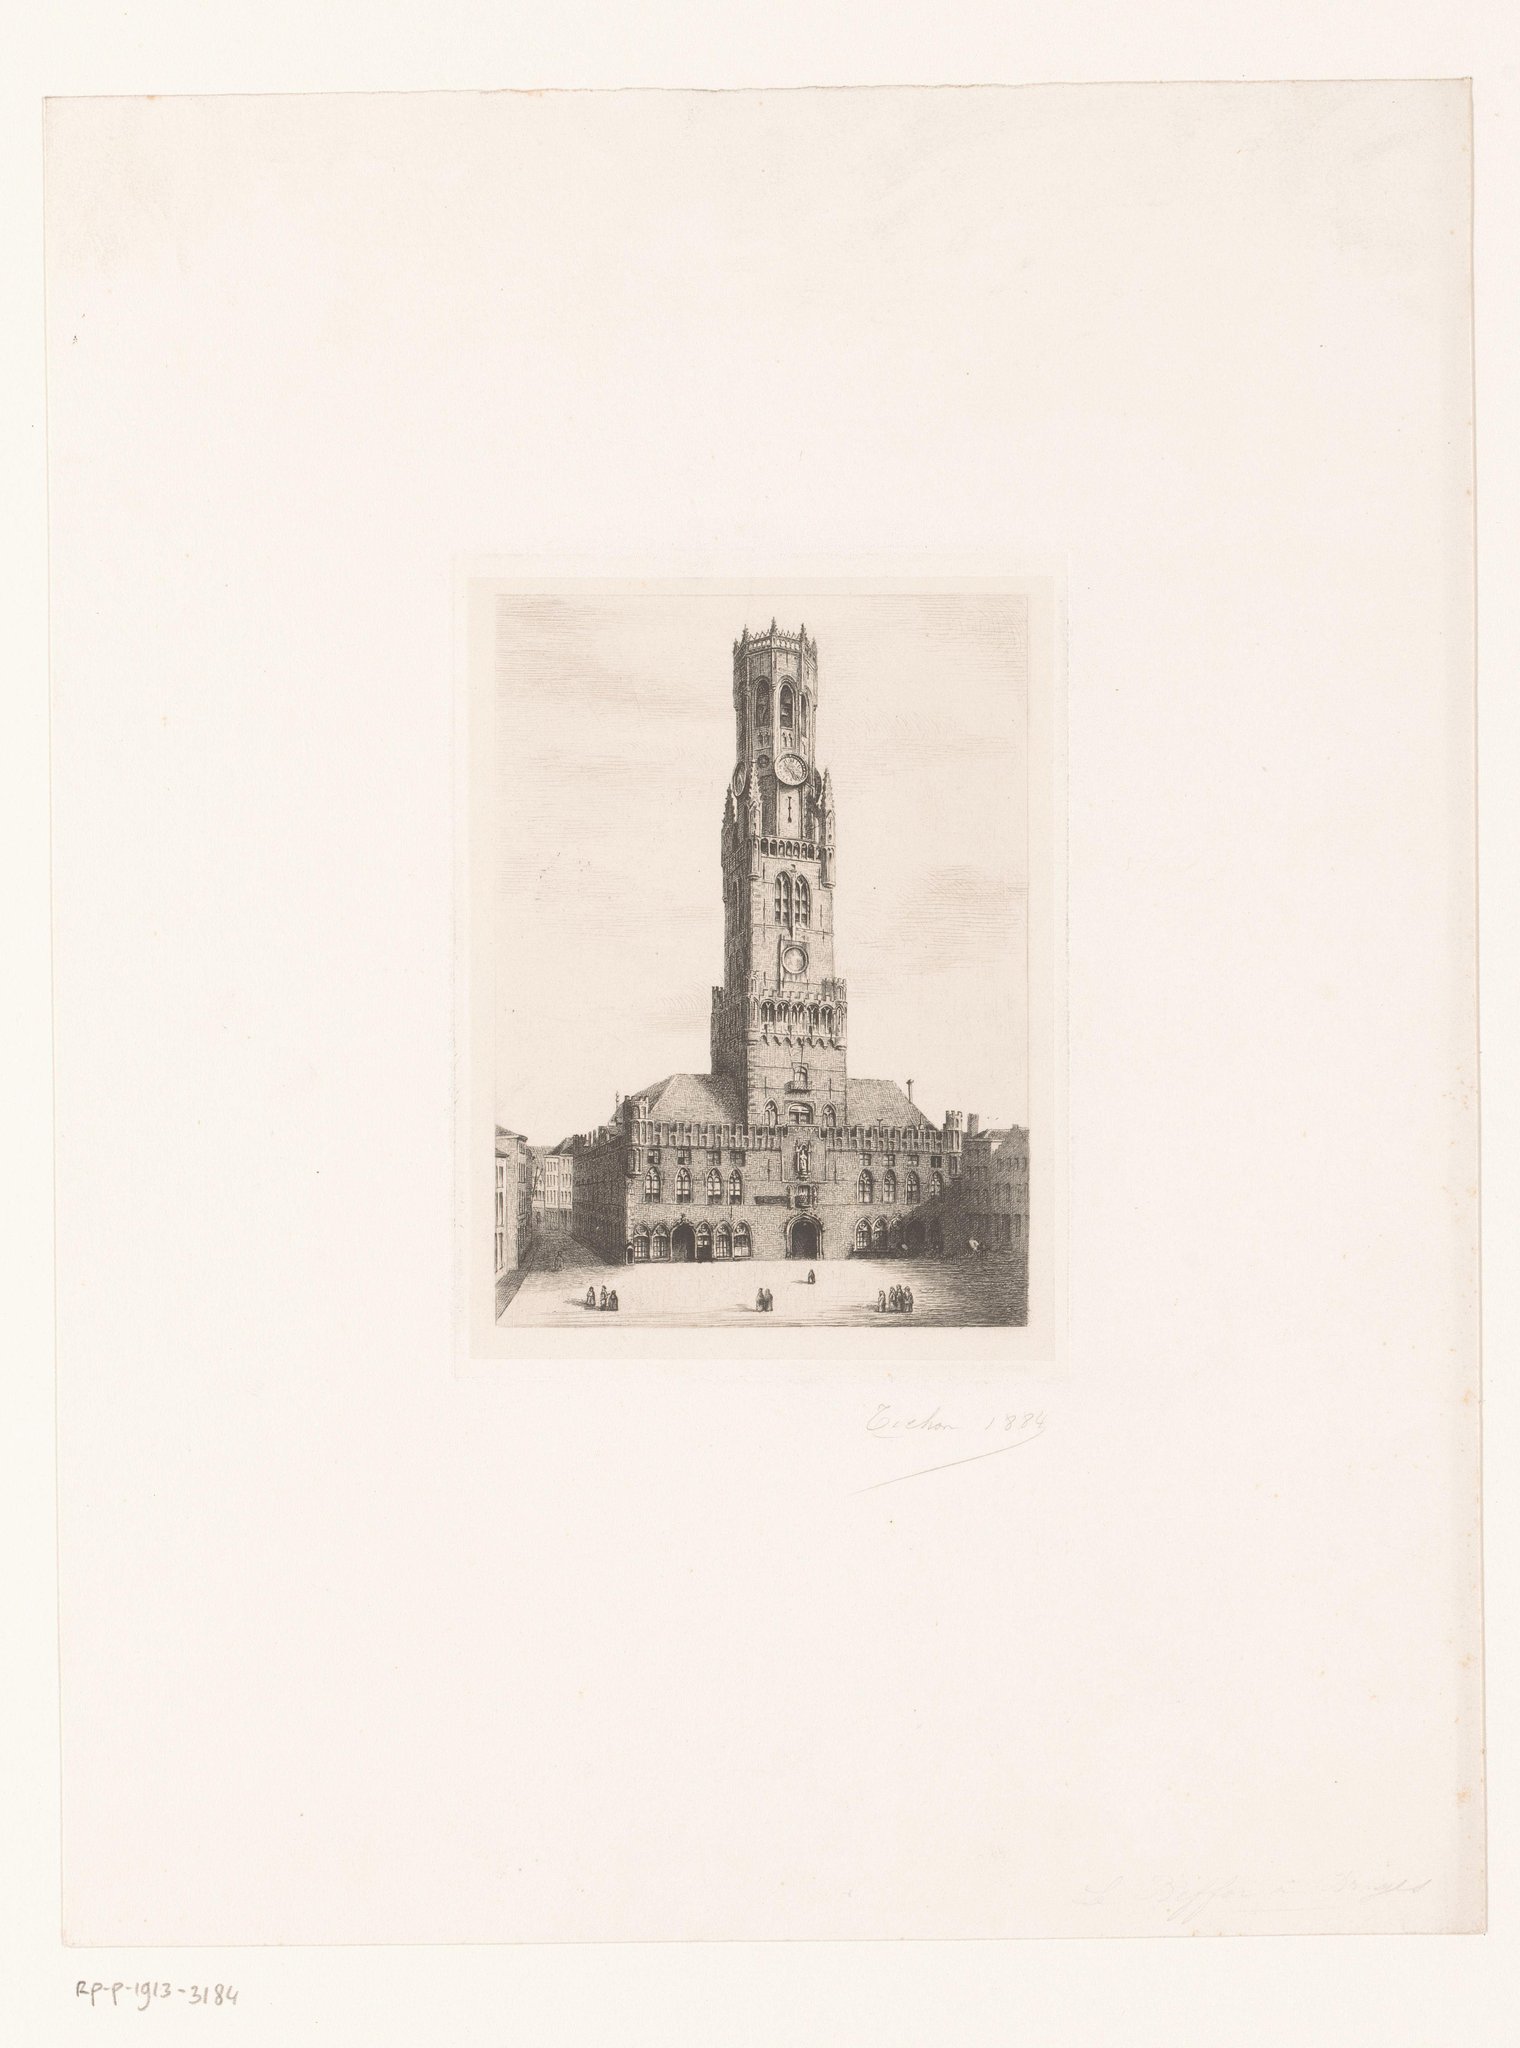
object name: print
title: Belfort te Brugge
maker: charles tichon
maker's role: draughtsman, painter, print maker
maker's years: 1865-1924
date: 1884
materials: paper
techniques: etching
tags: tower, clock tower ~ monumental adornment, tower (of house or building)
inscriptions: collector's mark: Lugt 2228